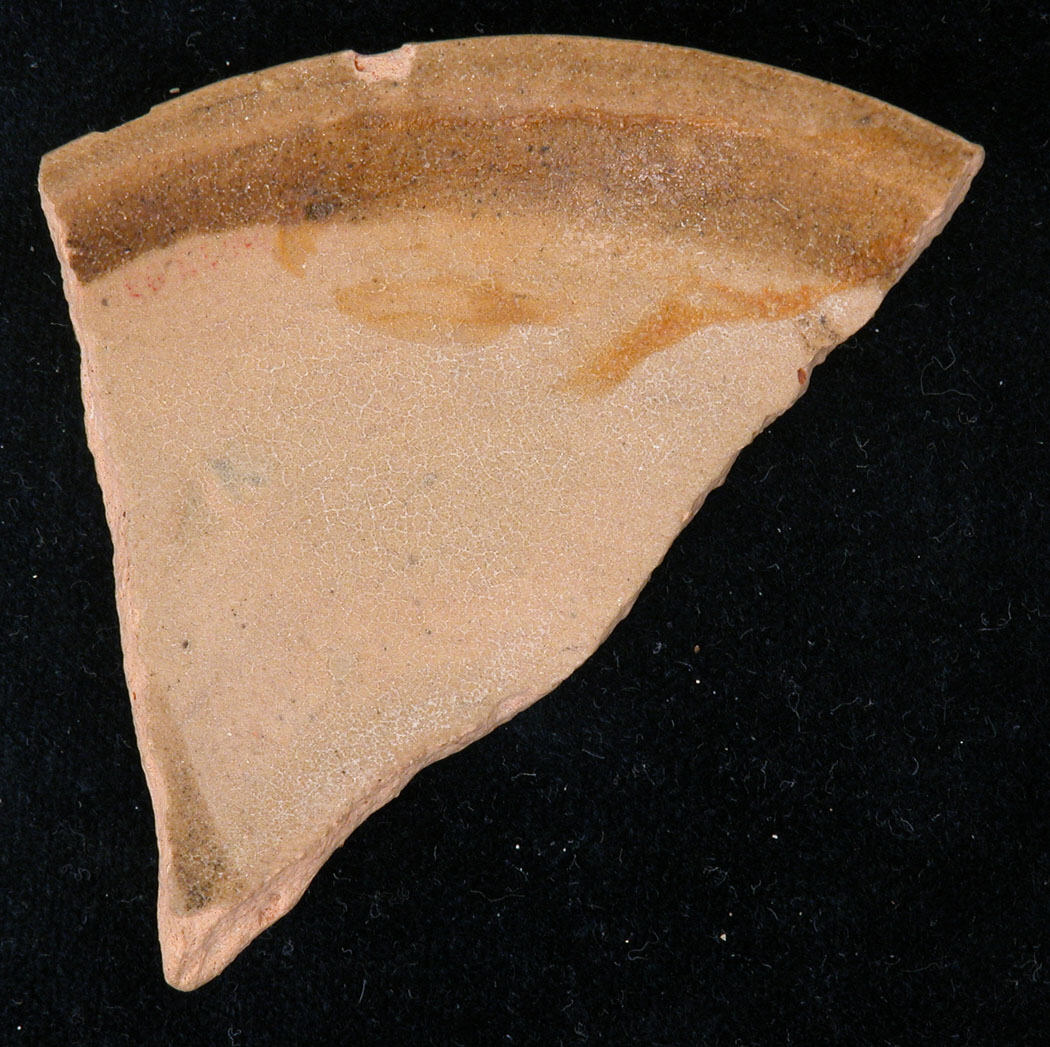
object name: fragment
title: Ceramic Fragment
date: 801-1000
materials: earthenware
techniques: glazing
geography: saudi arabia